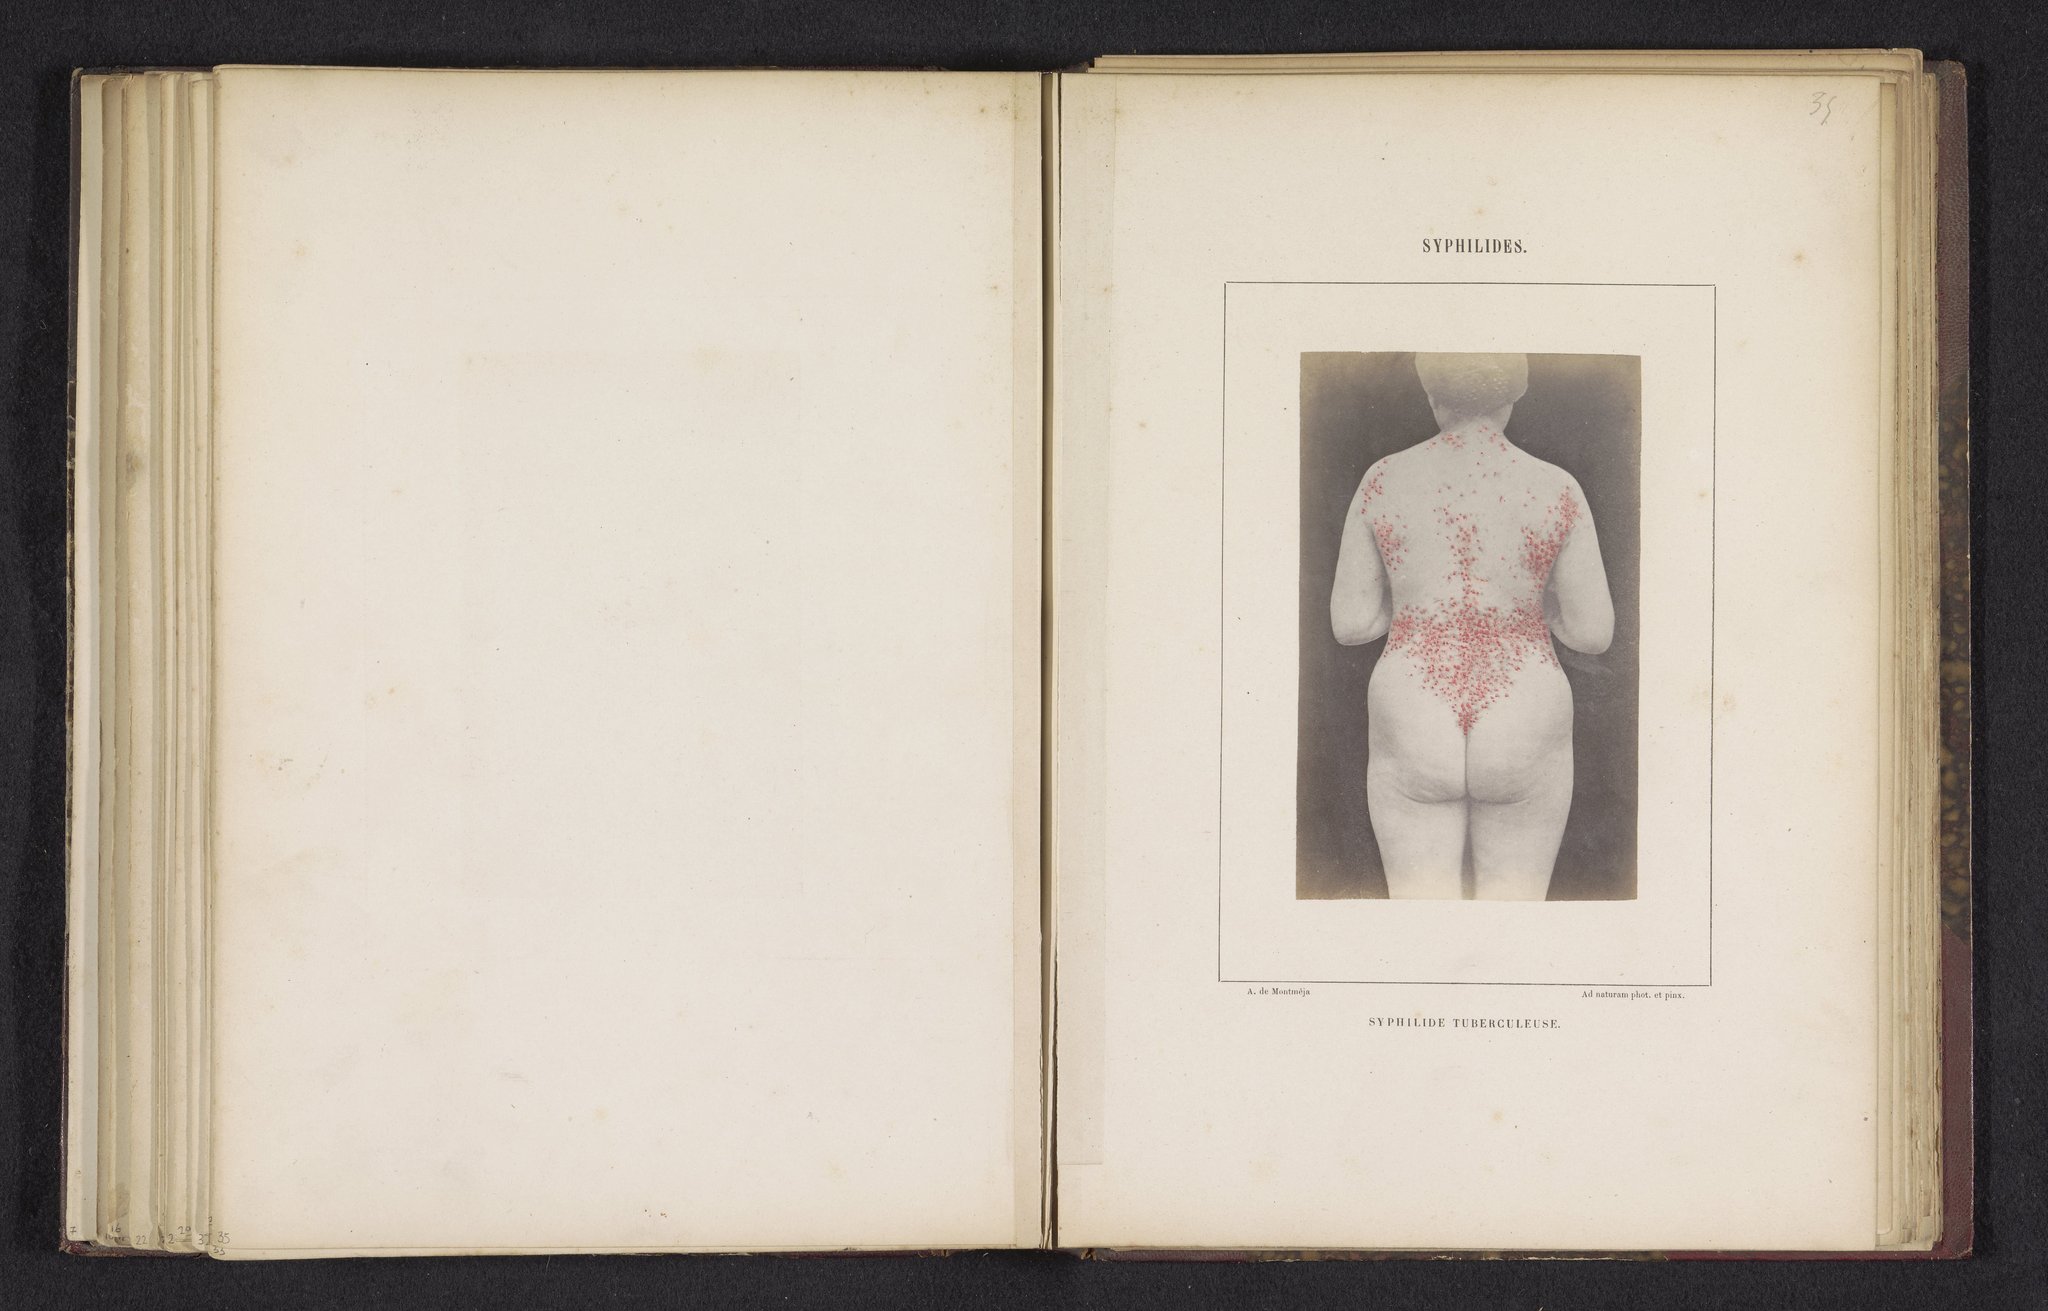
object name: page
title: Vrouw met huiduitslag veroorzaakt door syfilis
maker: a. de montméja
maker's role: arts, fotograaf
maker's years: 1841-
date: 1860-1868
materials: photographic support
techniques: albumen print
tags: skin and venereal diseases: syphilis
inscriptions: inscription: ‘Ad naturam phot. et pinx.’, inscription: ‘Syphilides’, number: ‘35’